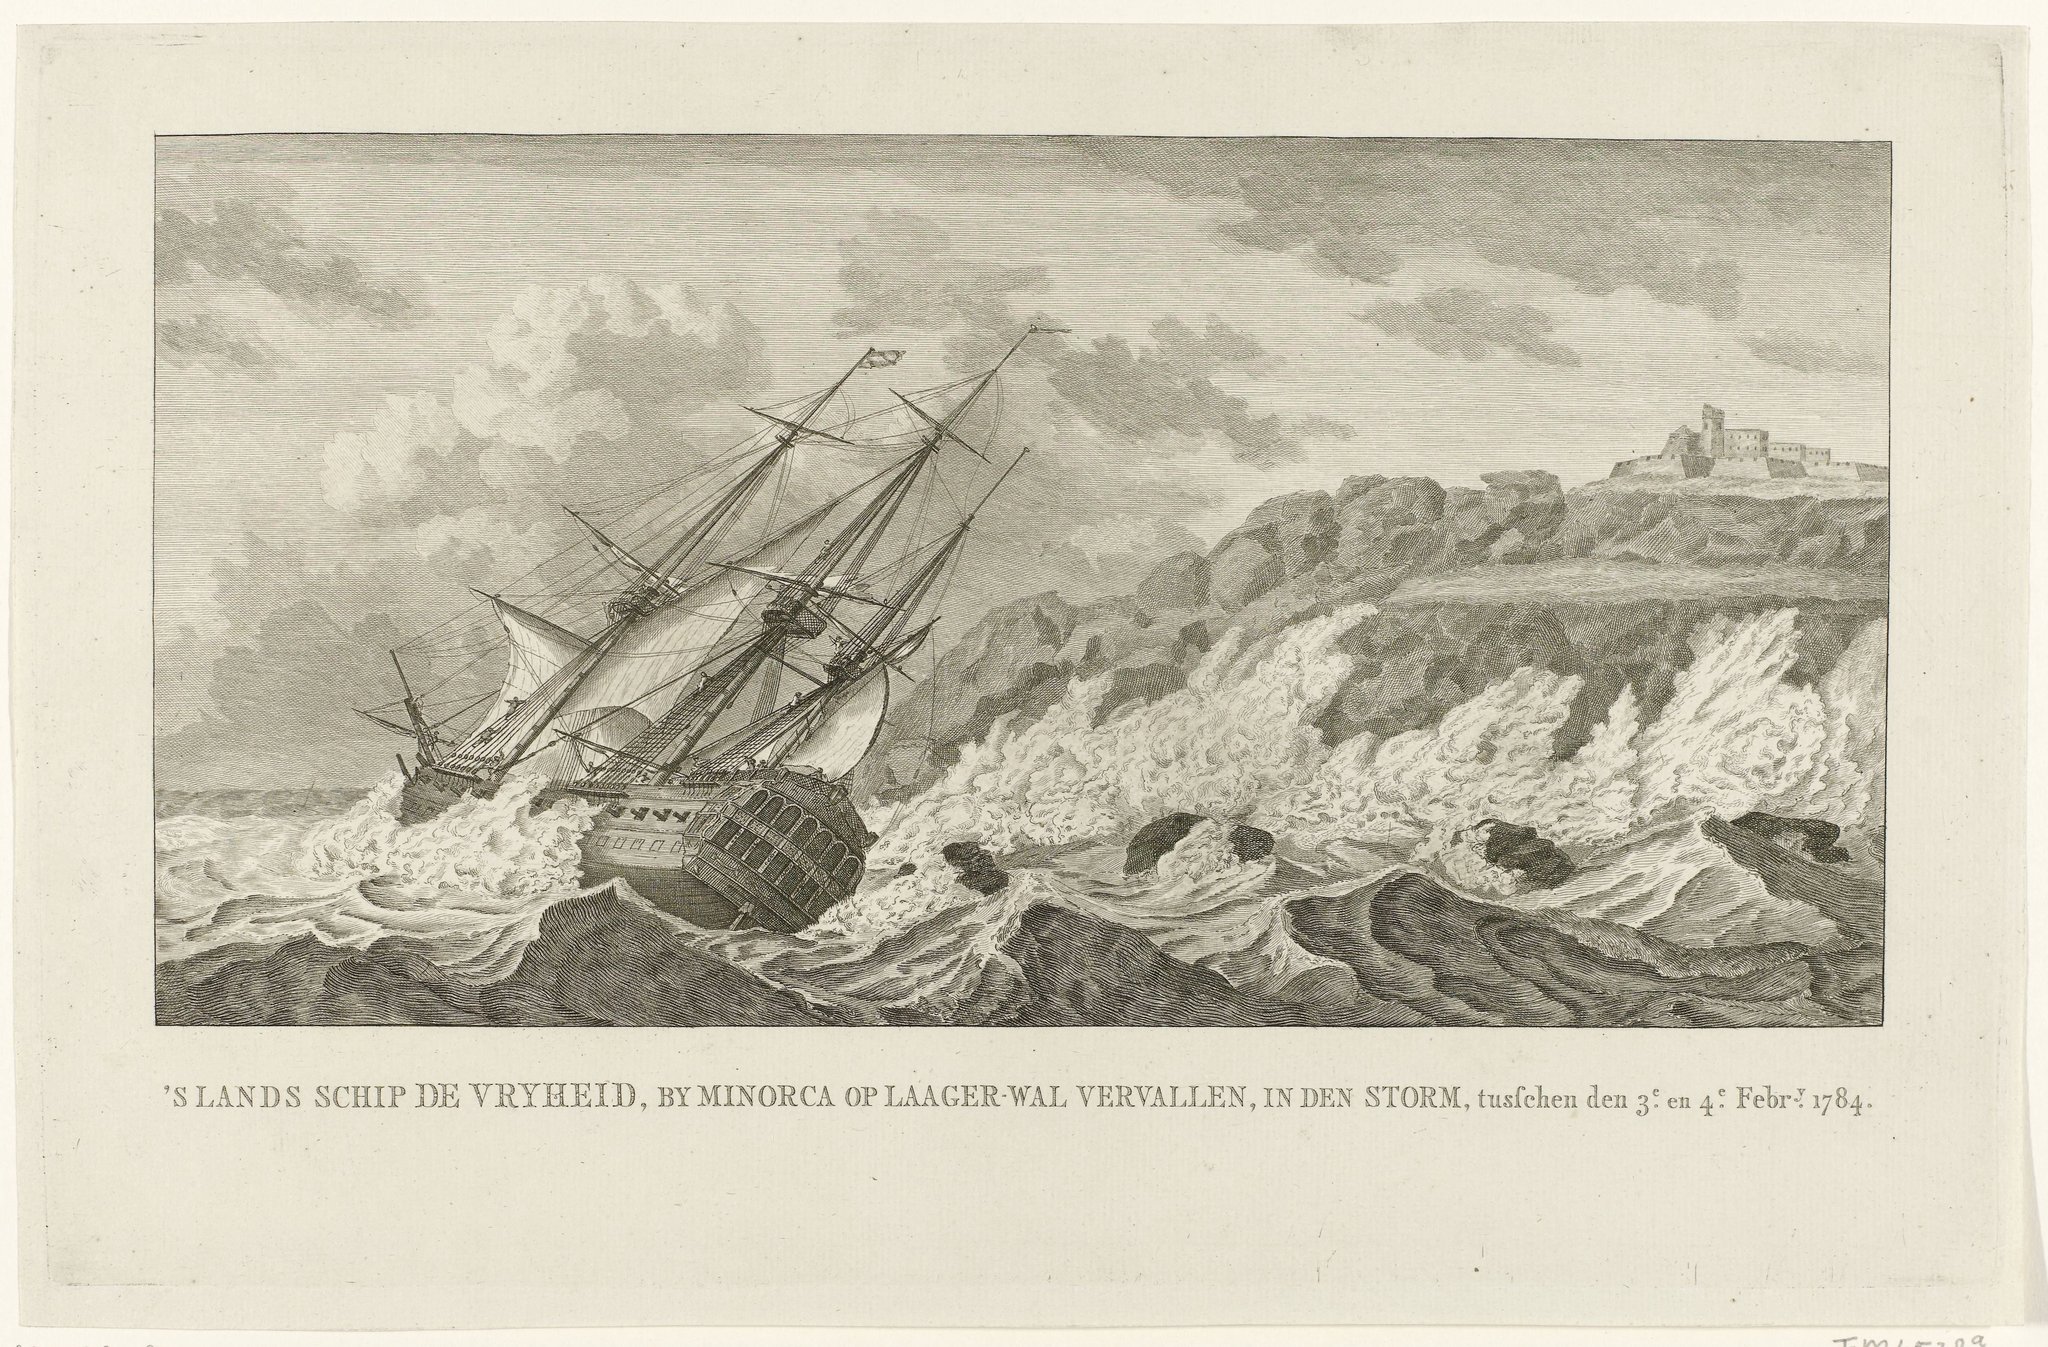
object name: print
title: Tweede en Laatste stel van Vier Kunstplaaten, verbeeldende Vaderlandsche Historien ter Zee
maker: carel frederik bendorp (i)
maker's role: print maker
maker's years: 1736-1814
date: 1784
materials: paper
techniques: engraving, etching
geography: northern netherlands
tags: amsterdam, arnhem, pieter hendrik reynst, shipwreck (+ propulsion of vehicle, ship, etc. by wind)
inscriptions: collector's mark: Lugt 2228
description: Het vergaan van het schip de Vrijheid onder bevel van vice-admiraal Reynst bij het eiland Minorca tijdens de storm van 3-4 februari 1784. Onderdeel van de serie van historische gebeurtenissen op zee in de jaren 1781-1784, tweede serie.